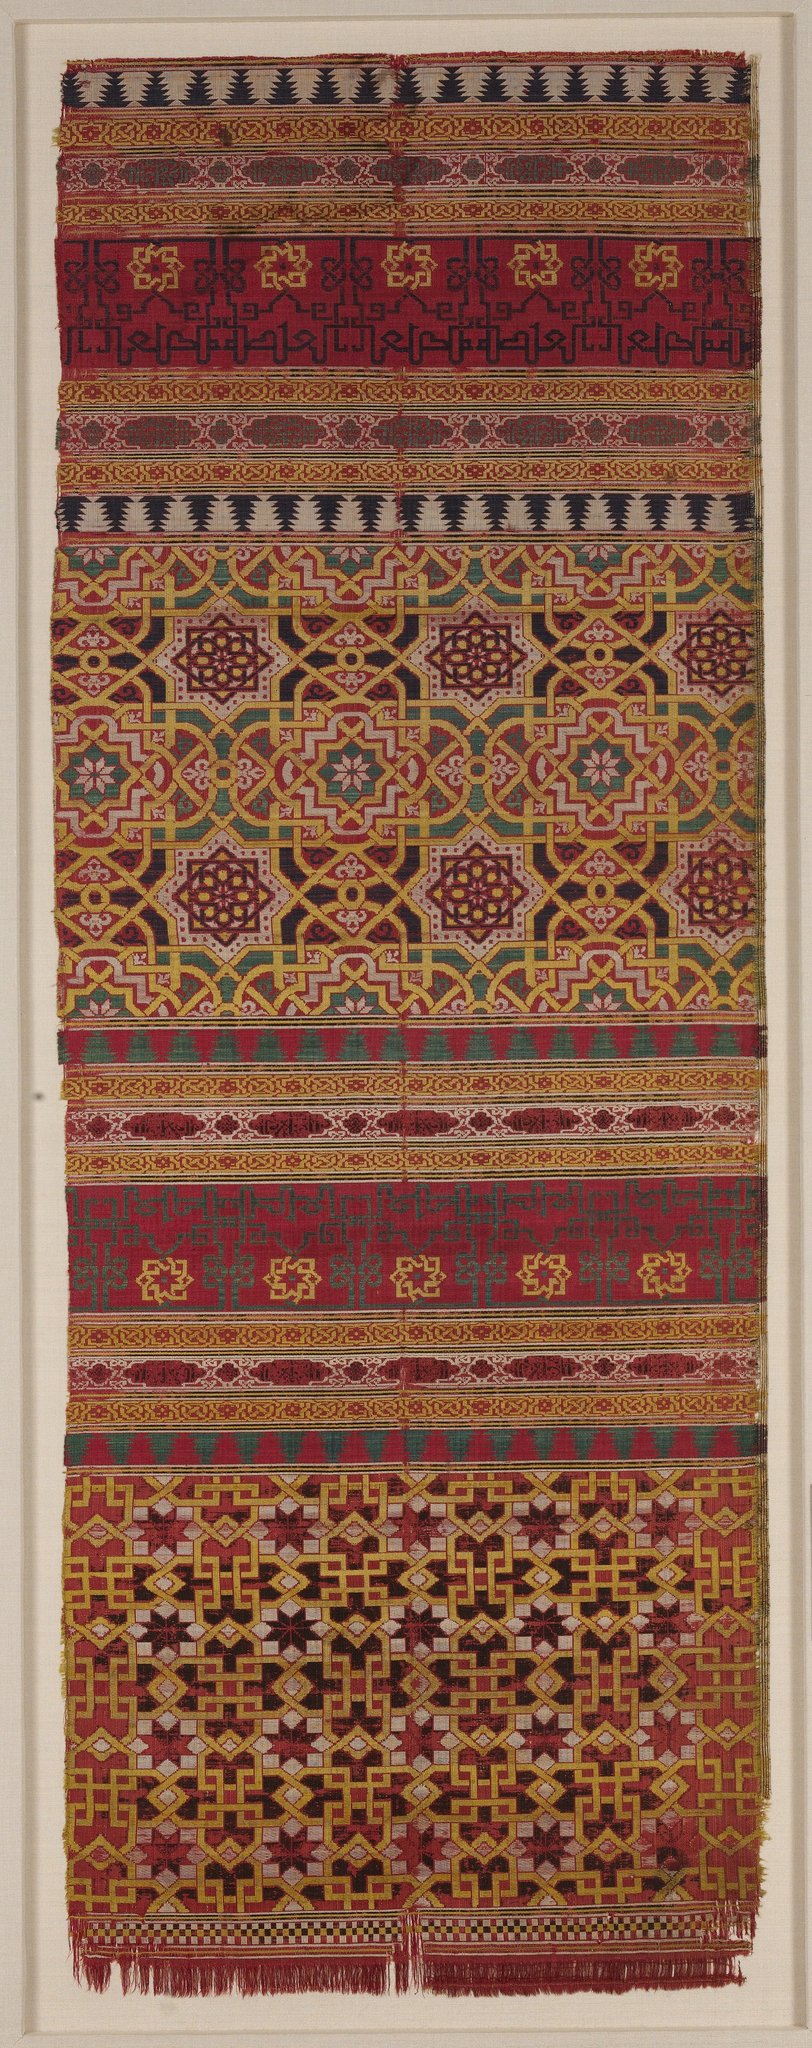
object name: textile fragment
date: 1301-1400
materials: silk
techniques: lampas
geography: spain